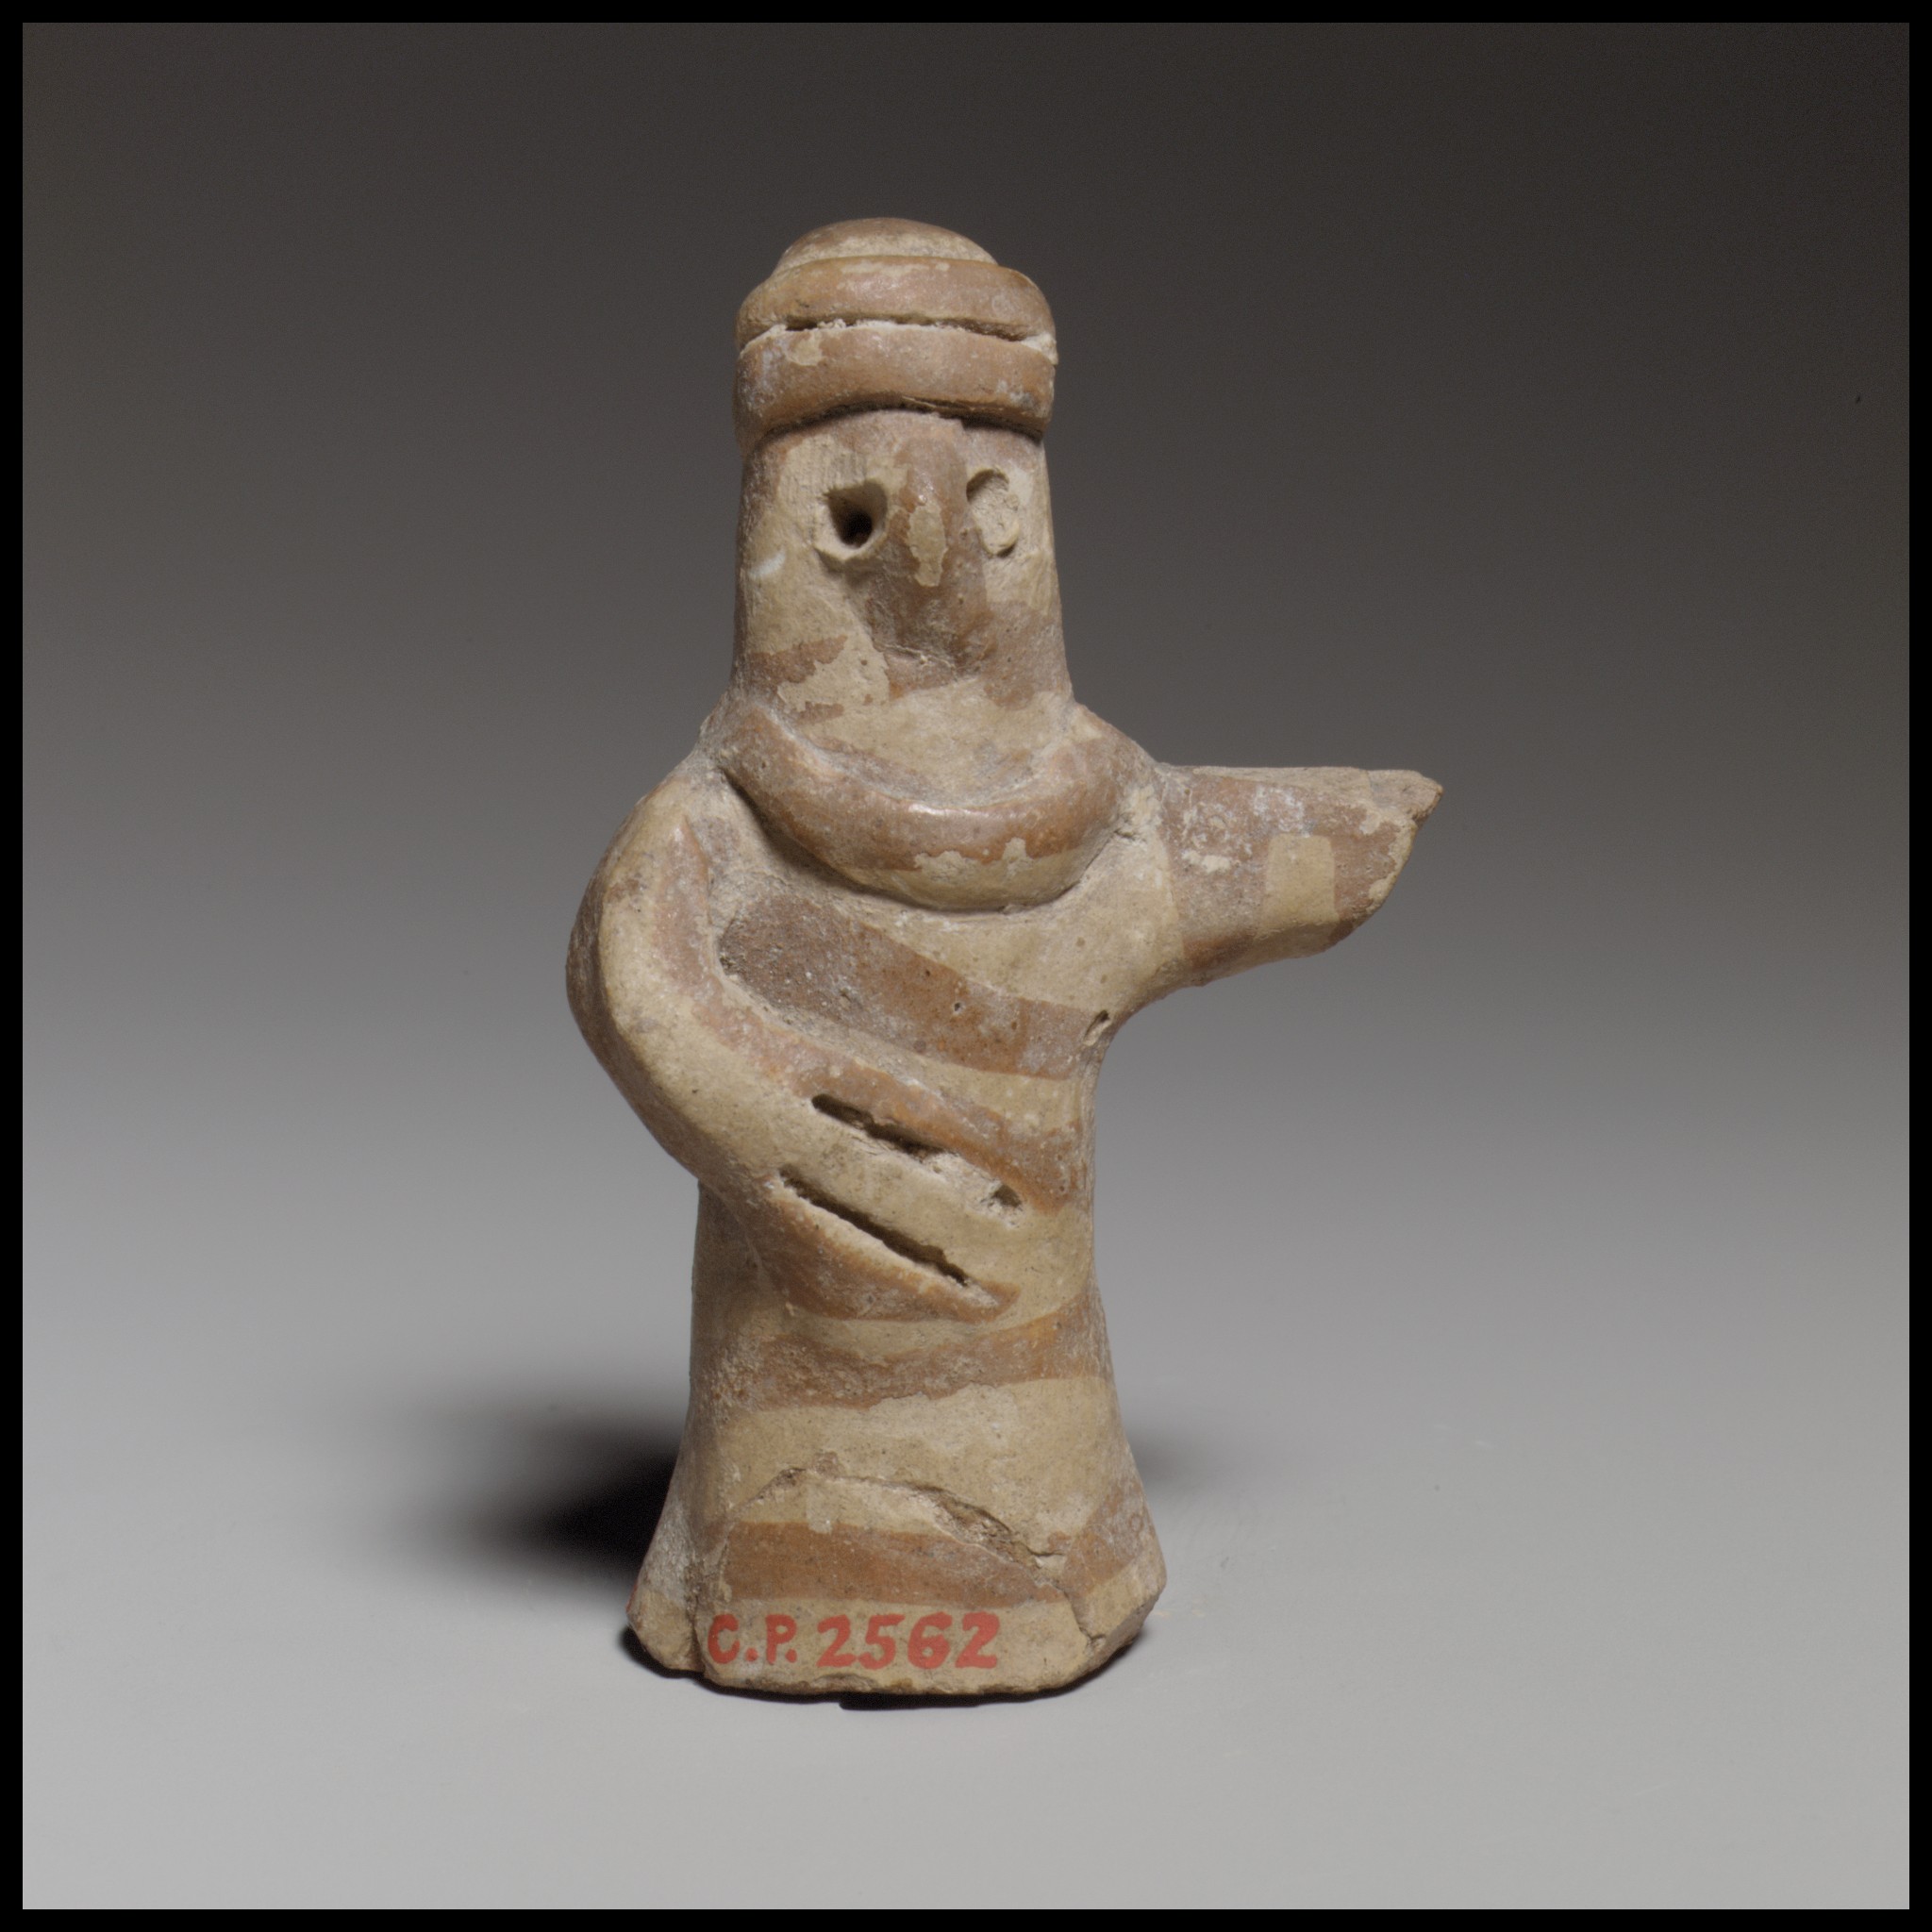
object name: statuette of a woman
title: Terracotta standing human figure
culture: cypriot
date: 1725-1450 BCE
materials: terracotta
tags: human figures